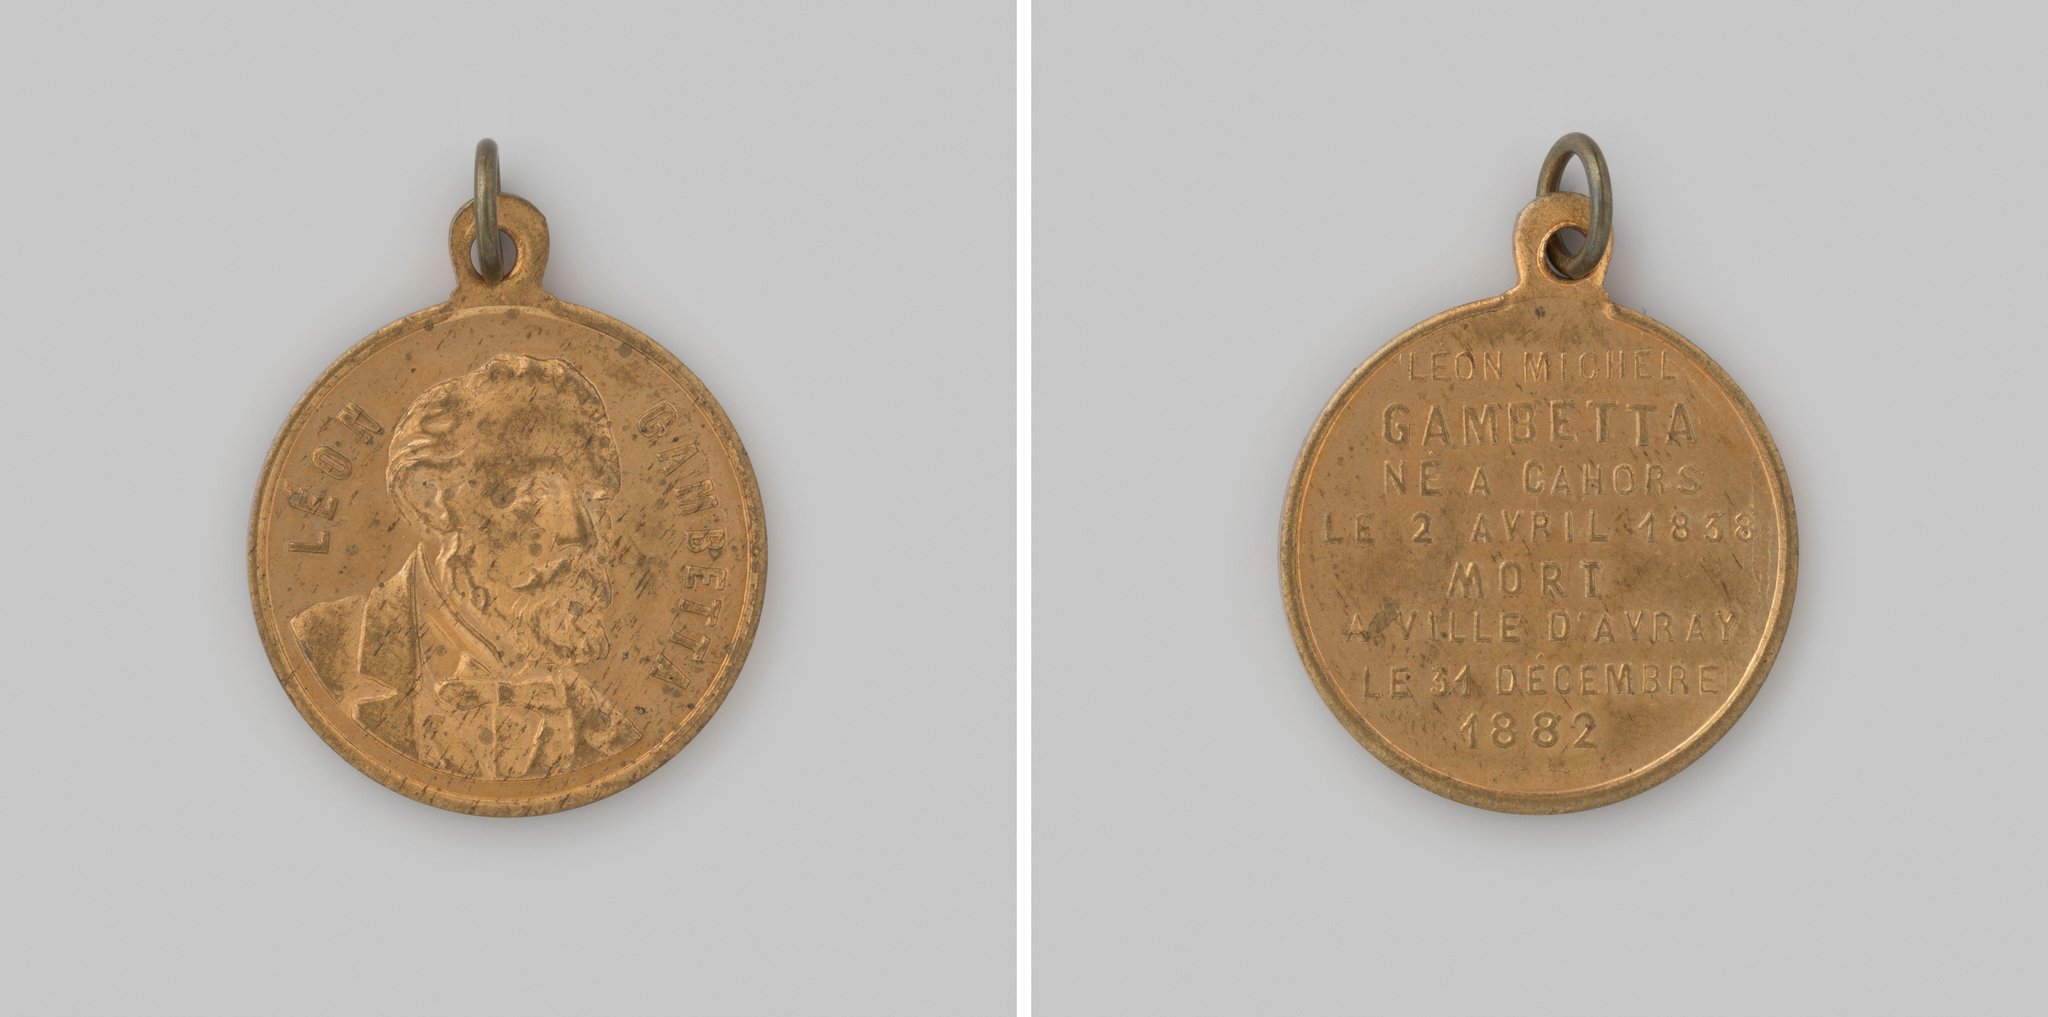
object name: history medal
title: Léon Michel Gambetta 1838-1882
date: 1882-1900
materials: brass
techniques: striking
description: Vergulde penning met oog en draagring, op de voorzijde het borstbeeld van Gambetta half naar rechts met omschrift, op de keerzijde acht regels tekst.